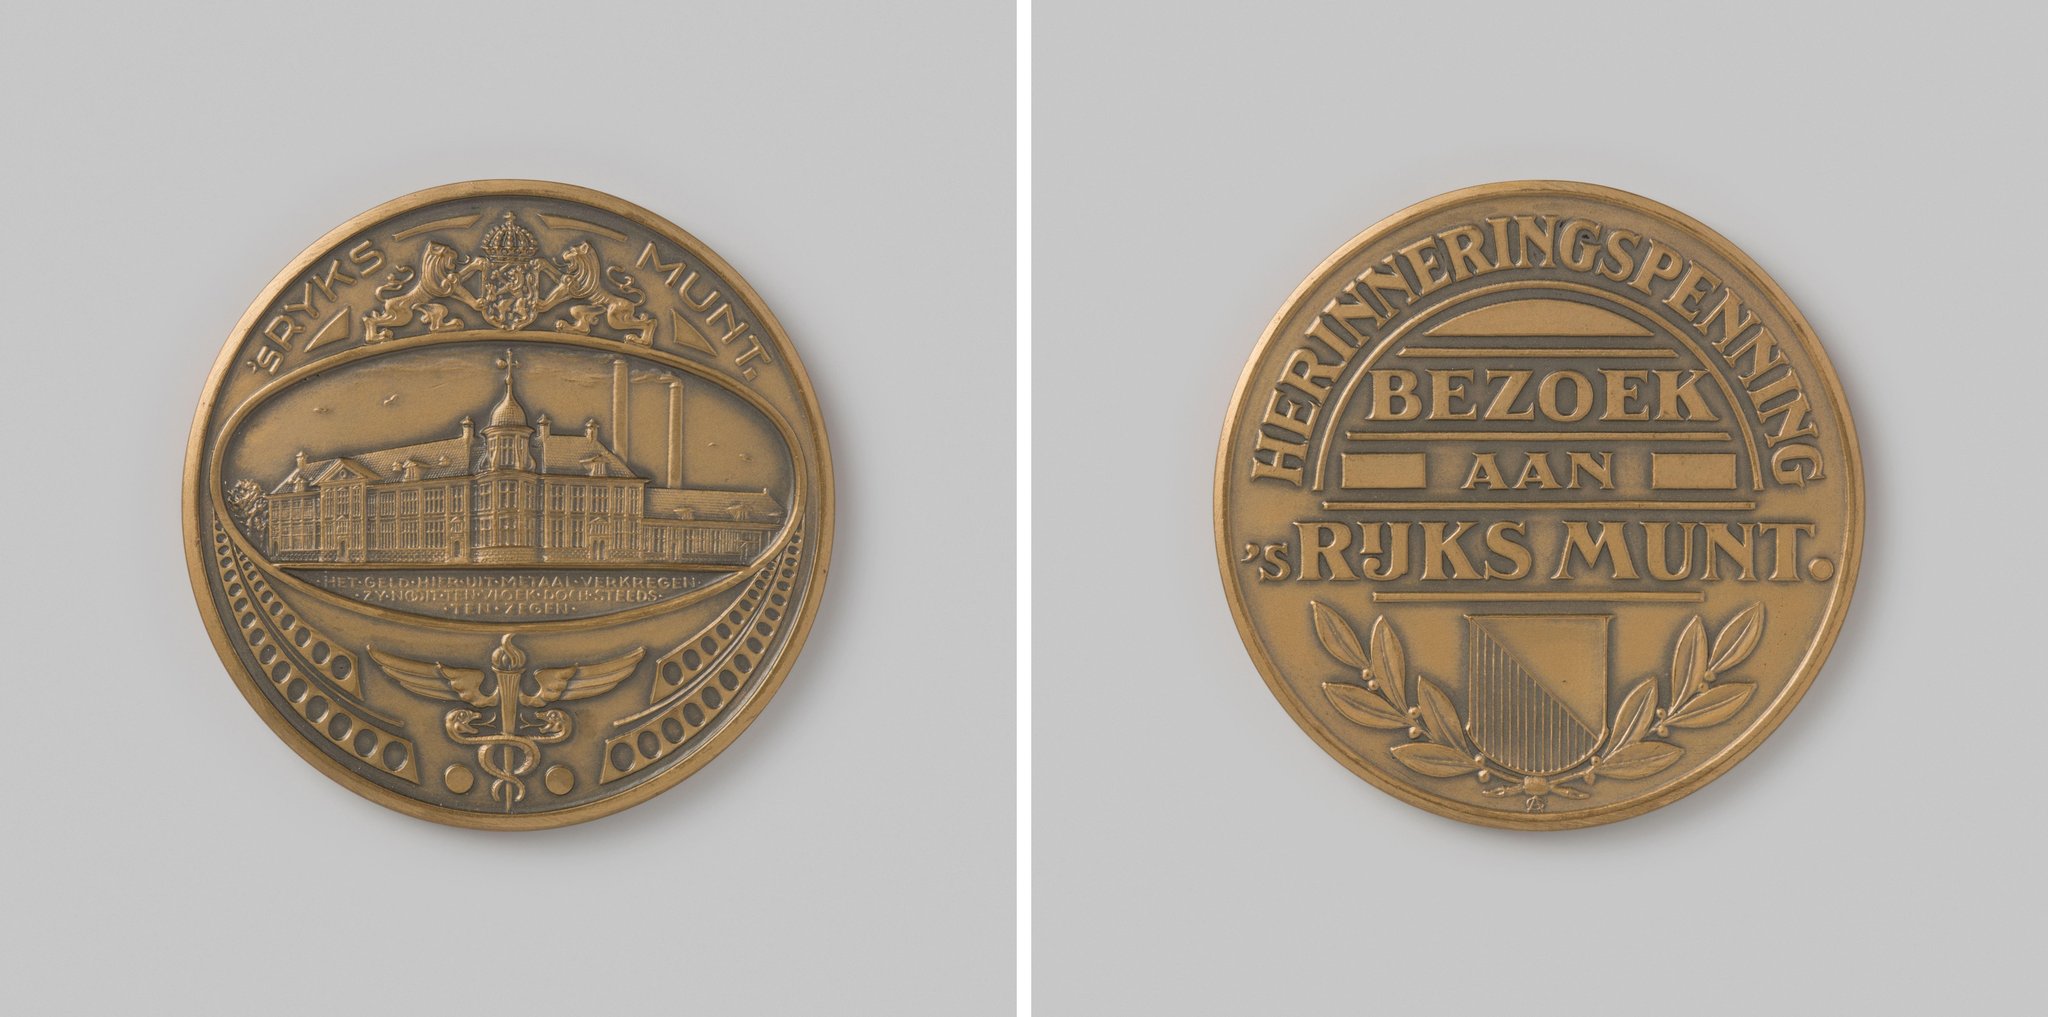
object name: commemorative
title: Herinneringspenning bezoek aan 's Rijks Munt; muntcommissie 1945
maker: monogrammist ag (20e eeuw)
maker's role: medailleur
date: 1949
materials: bronze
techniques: striking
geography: netherlands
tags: 's rijks munt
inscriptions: edge inscription: ‘MUNTCOMMISSIE 1945 7 MAART 1949’